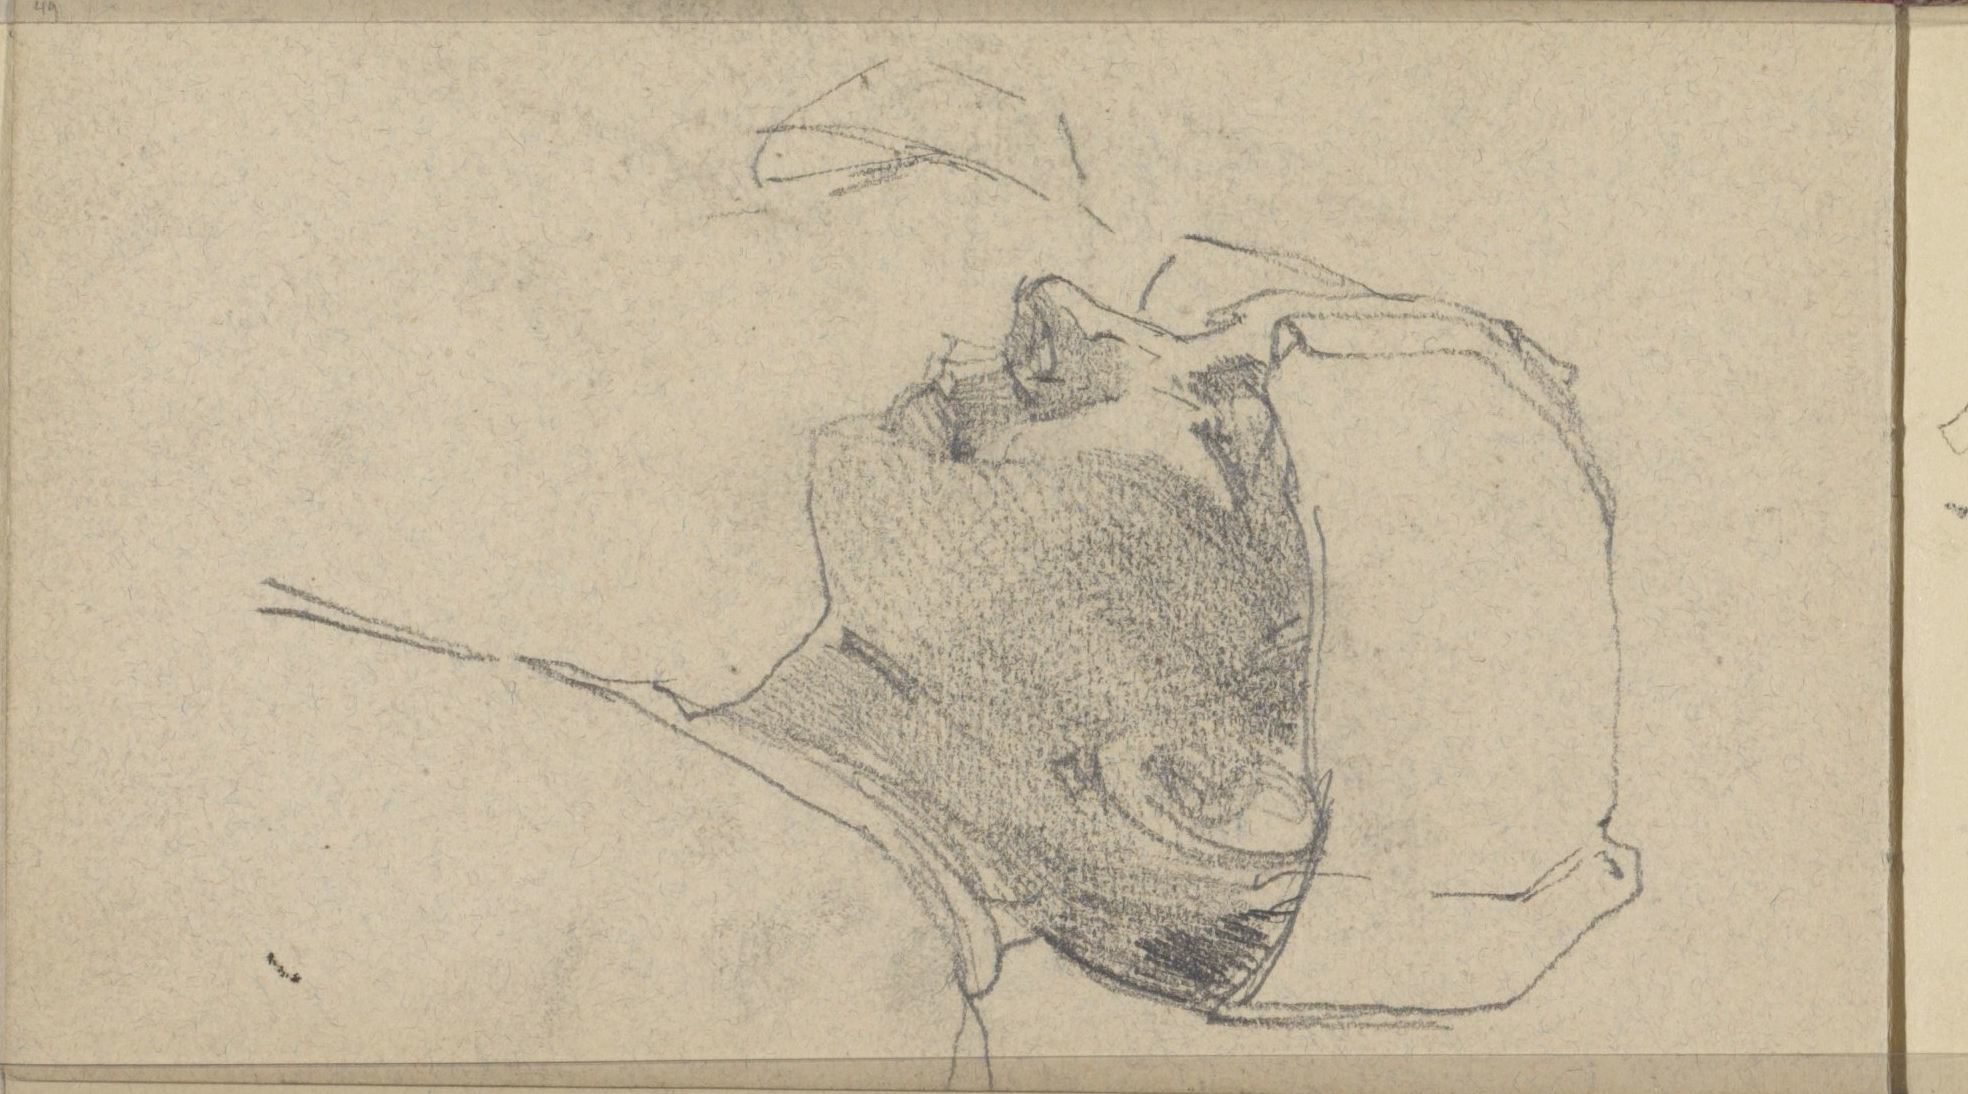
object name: sketchbook leaf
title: Buste van een jonge man met hoofddeksel, in profiel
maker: george hendrik breitner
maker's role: draughtsman, painter, print maker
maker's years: 1857-1923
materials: paper, pencil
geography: amsterdam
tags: head-gear (+ men's clothes), youth, adolescent (+ sideview, profile)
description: Pagina 49 uit een schetsboek met 32 bladen.